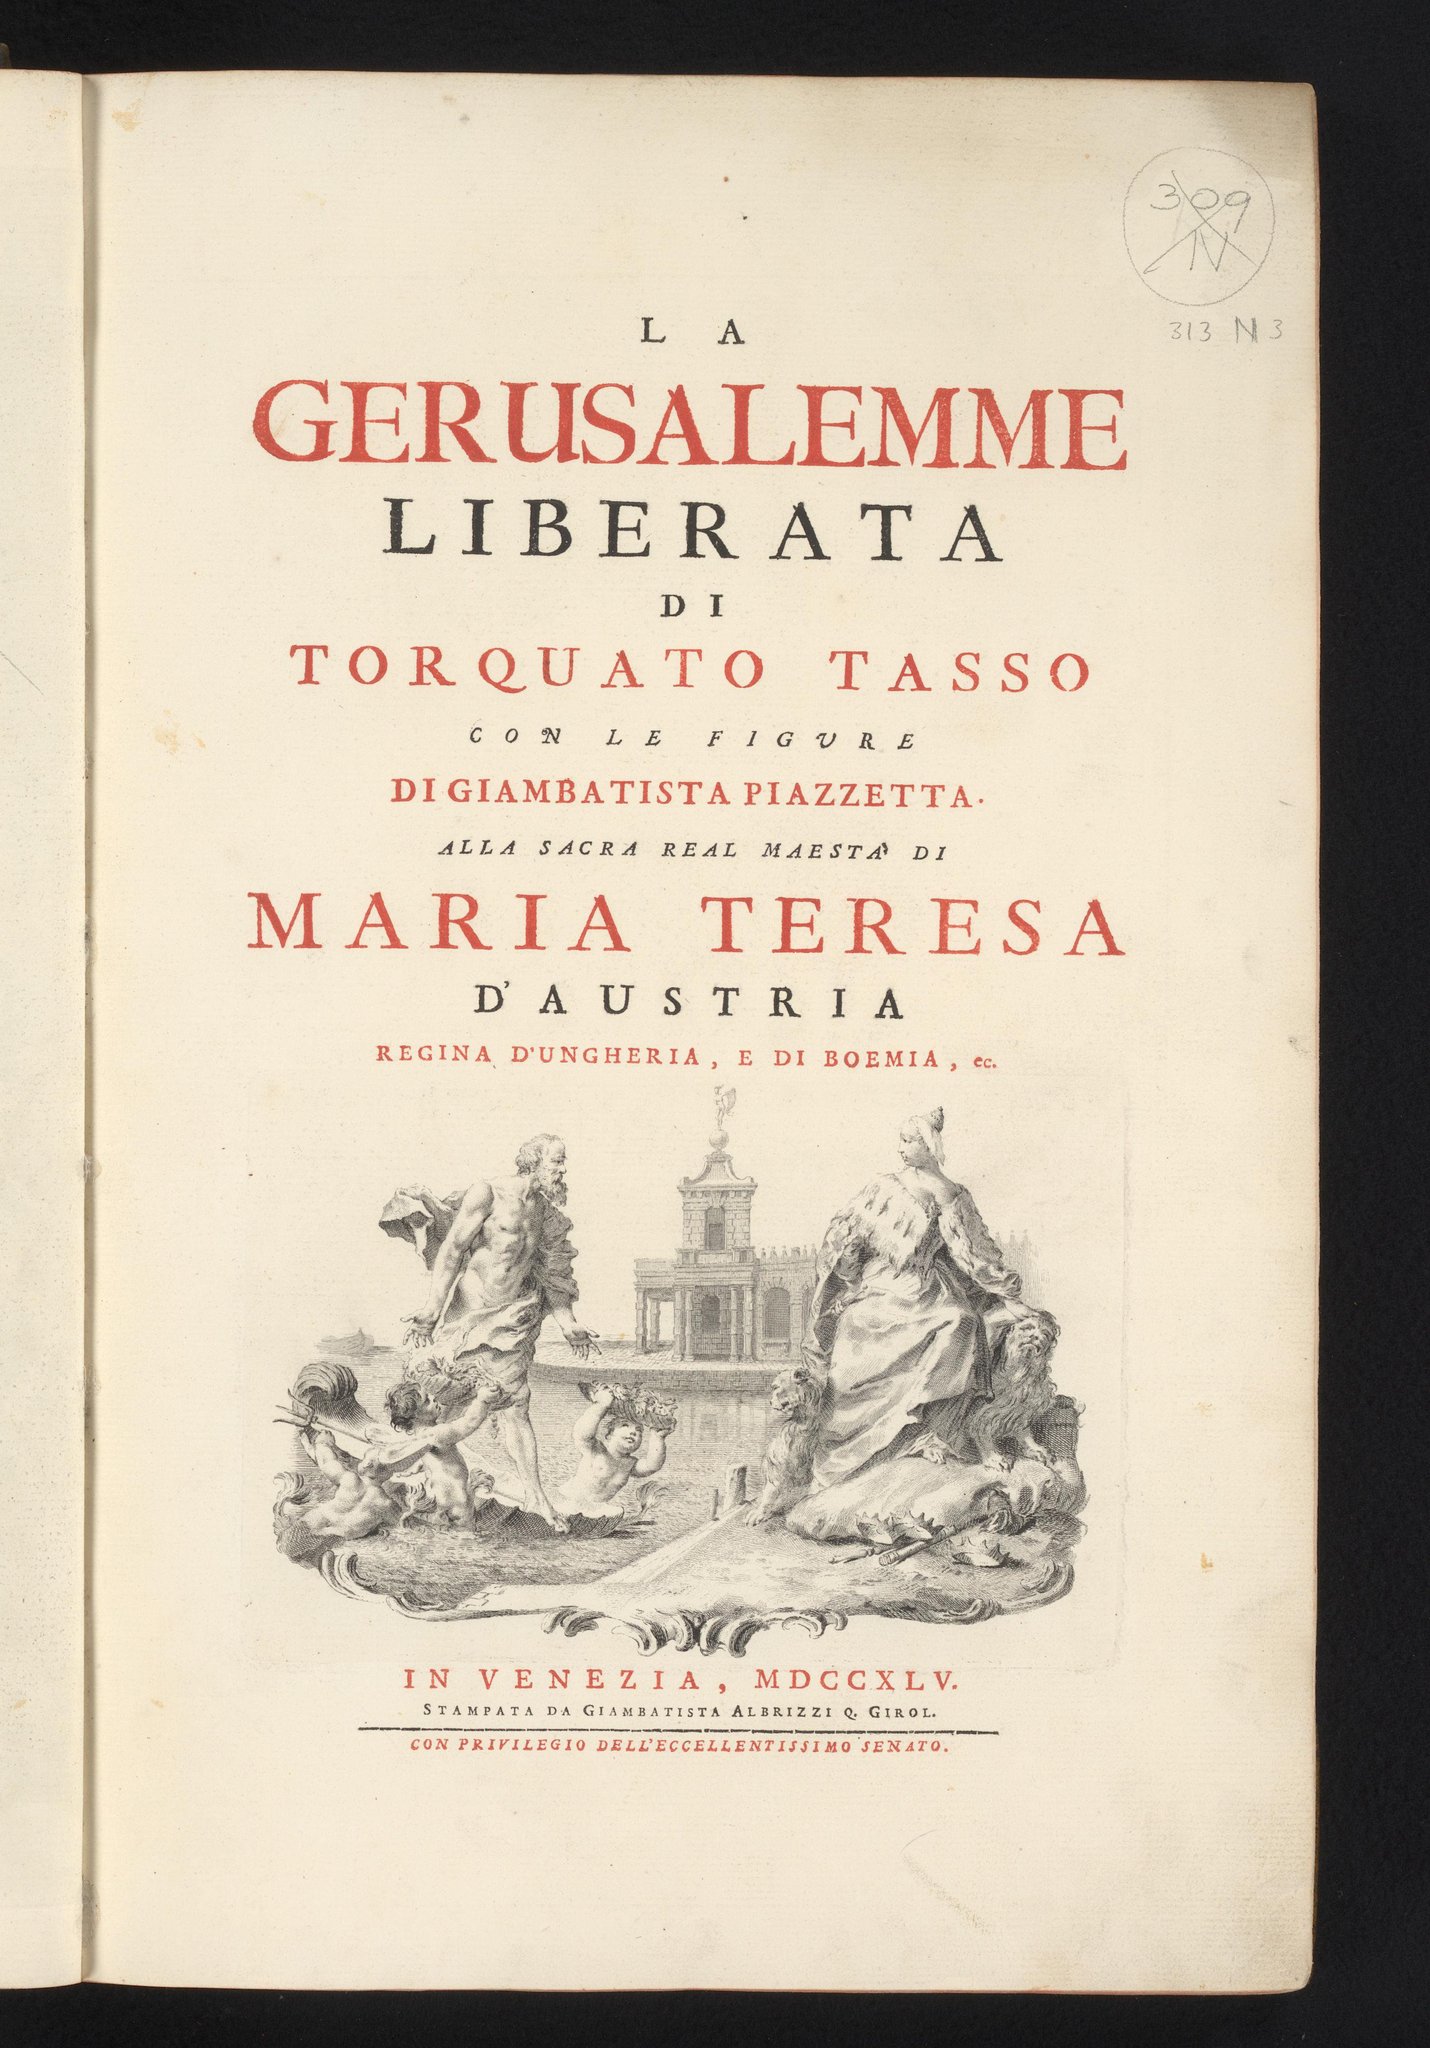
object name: book illustration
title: Torquato Tasso ontvangen door de maagd van Venetië en twee leeuwen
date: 1745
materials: paper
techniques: engraving, etching, letterpress printing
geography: venice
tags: rome, torquato tasso, title-page, writer, poet, author, (scenes from) specific works of literature: tasso, gerusalemme liberata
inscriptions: collector's mark: ‘Bibliotheek Rijksmuseum Amsterdam’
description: Titelpagina voor: Tasso, Torquato. La Gerusalemme liberata di Torquato Tasso con le figure de Giambatista Piazzetta. Venetië: Giambatista Albrizzi, 1745.